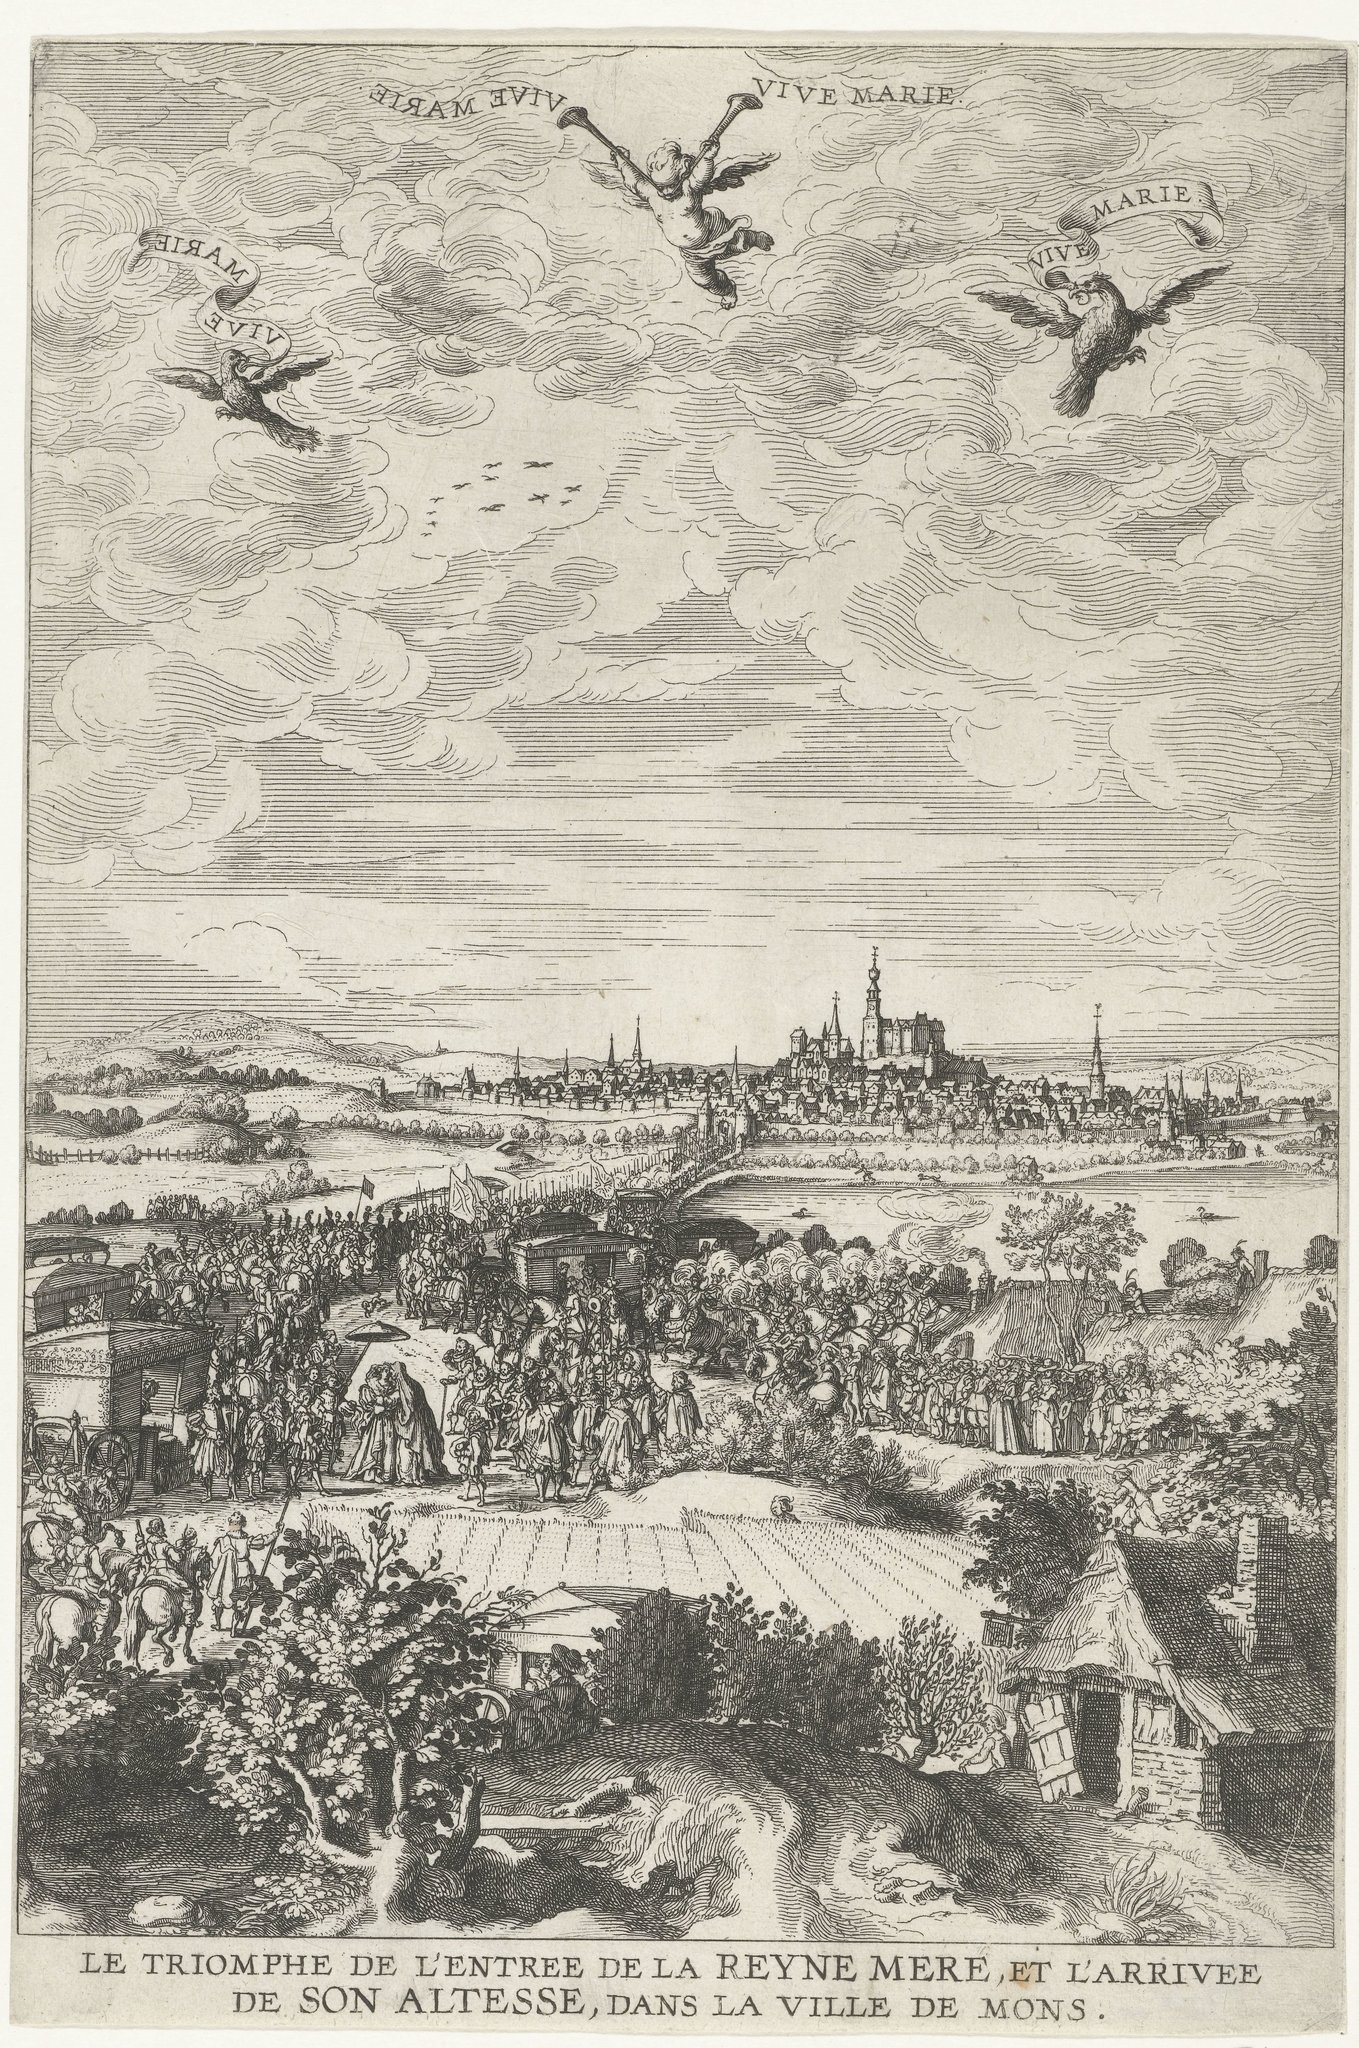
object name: print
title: Le triomphe de l'entree de la Reyne Mere, et l'arrivee de Son Altesse, dans la ville de Mons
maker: andries pauli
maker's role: print maker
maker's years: 1600-1639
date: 1631-1632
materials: paper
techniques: etching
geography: southern netherlands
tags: infante van spanje isabella clara eugenia, cologne, maria de' medici, triumphal entry and public reception, pageant, 'entrée solennelle', 'joyeuse entrée'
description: Gebruikt als illustratie in: Jean Puget de La Serre, Histoire curieuse de tout ce qui c'est passé à l'entrée de la reyne mère du roy trèschrestien dans les villes des Pays Bas, l'imprimerie Plantinienne de Balthasar Moretus, Antwerpen 1632.